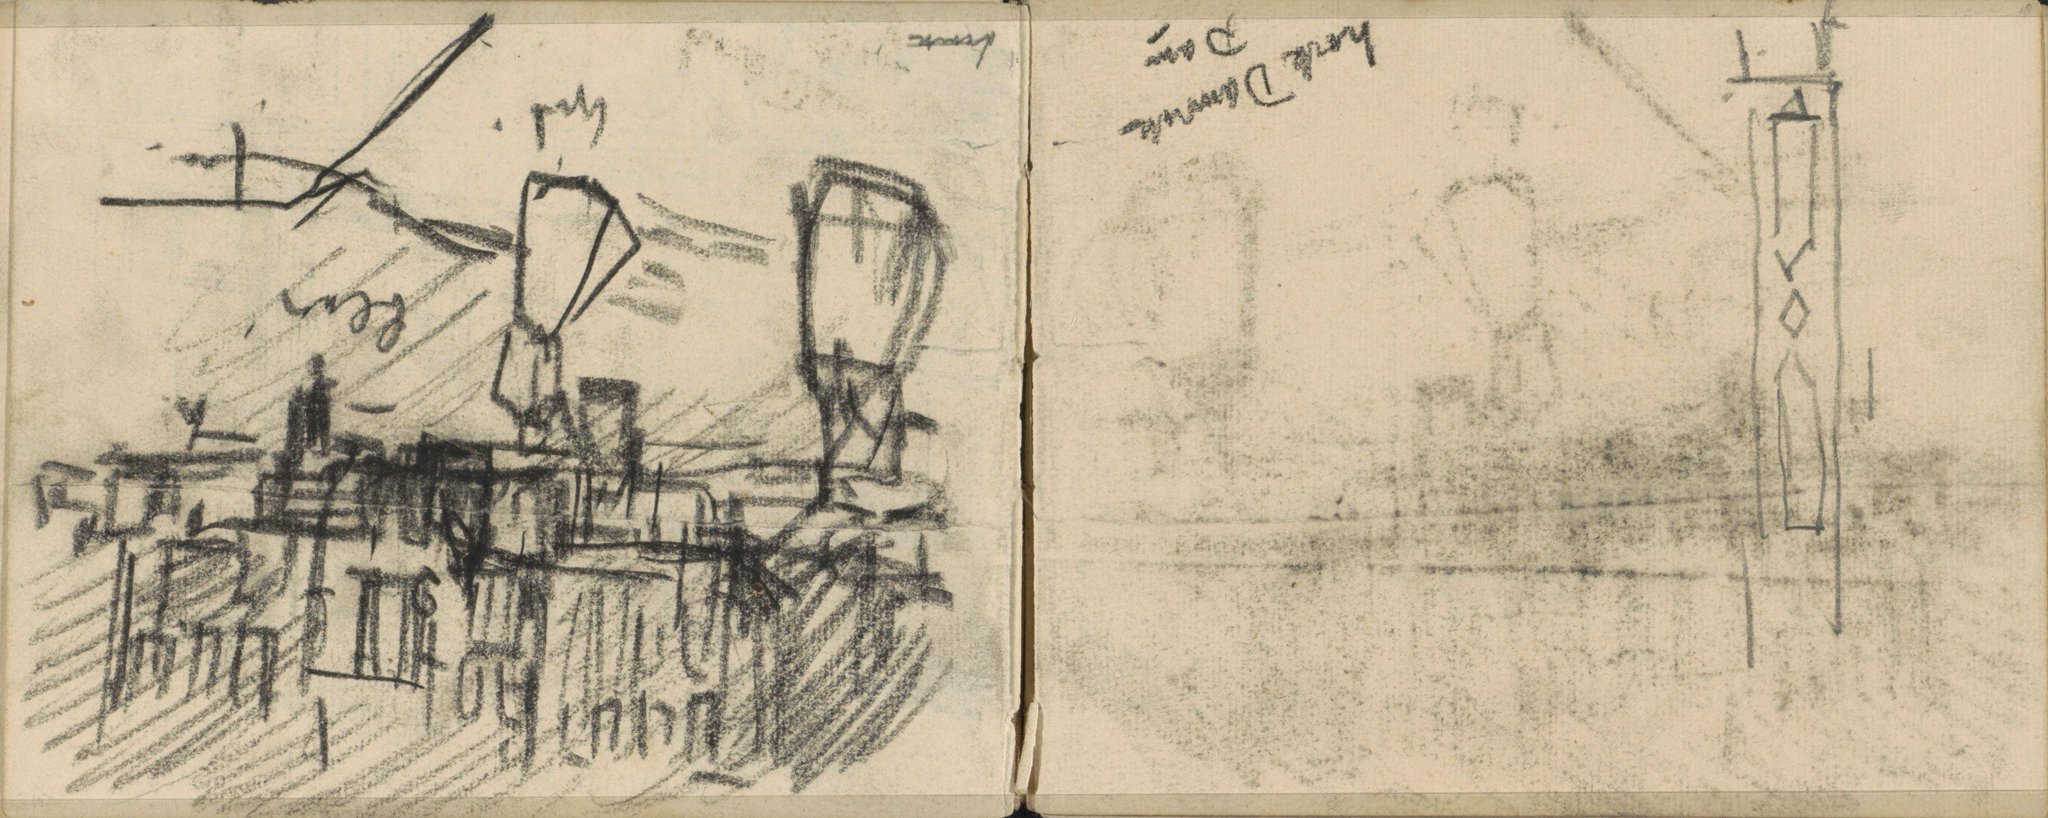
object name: sketchbook leaf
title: Gezicht op de hoek van de Dam en het Damrak te Amsterdam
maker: george hendrik breitner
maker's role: draughtsman, painter, print maker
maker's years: 1857-1923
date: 1893-1912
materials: chalk, paper, pencil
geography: amsterdam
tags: civic architecture; edifices; dwellings, square, place, circus, etc. (+ city(-scape) with figures, staffage)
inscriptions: annotation: ‘hoek Damrak/ Dam’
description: Verder een ornament. Pagina 17 en pagina 18 uit een schetsboek met 32 bladen.